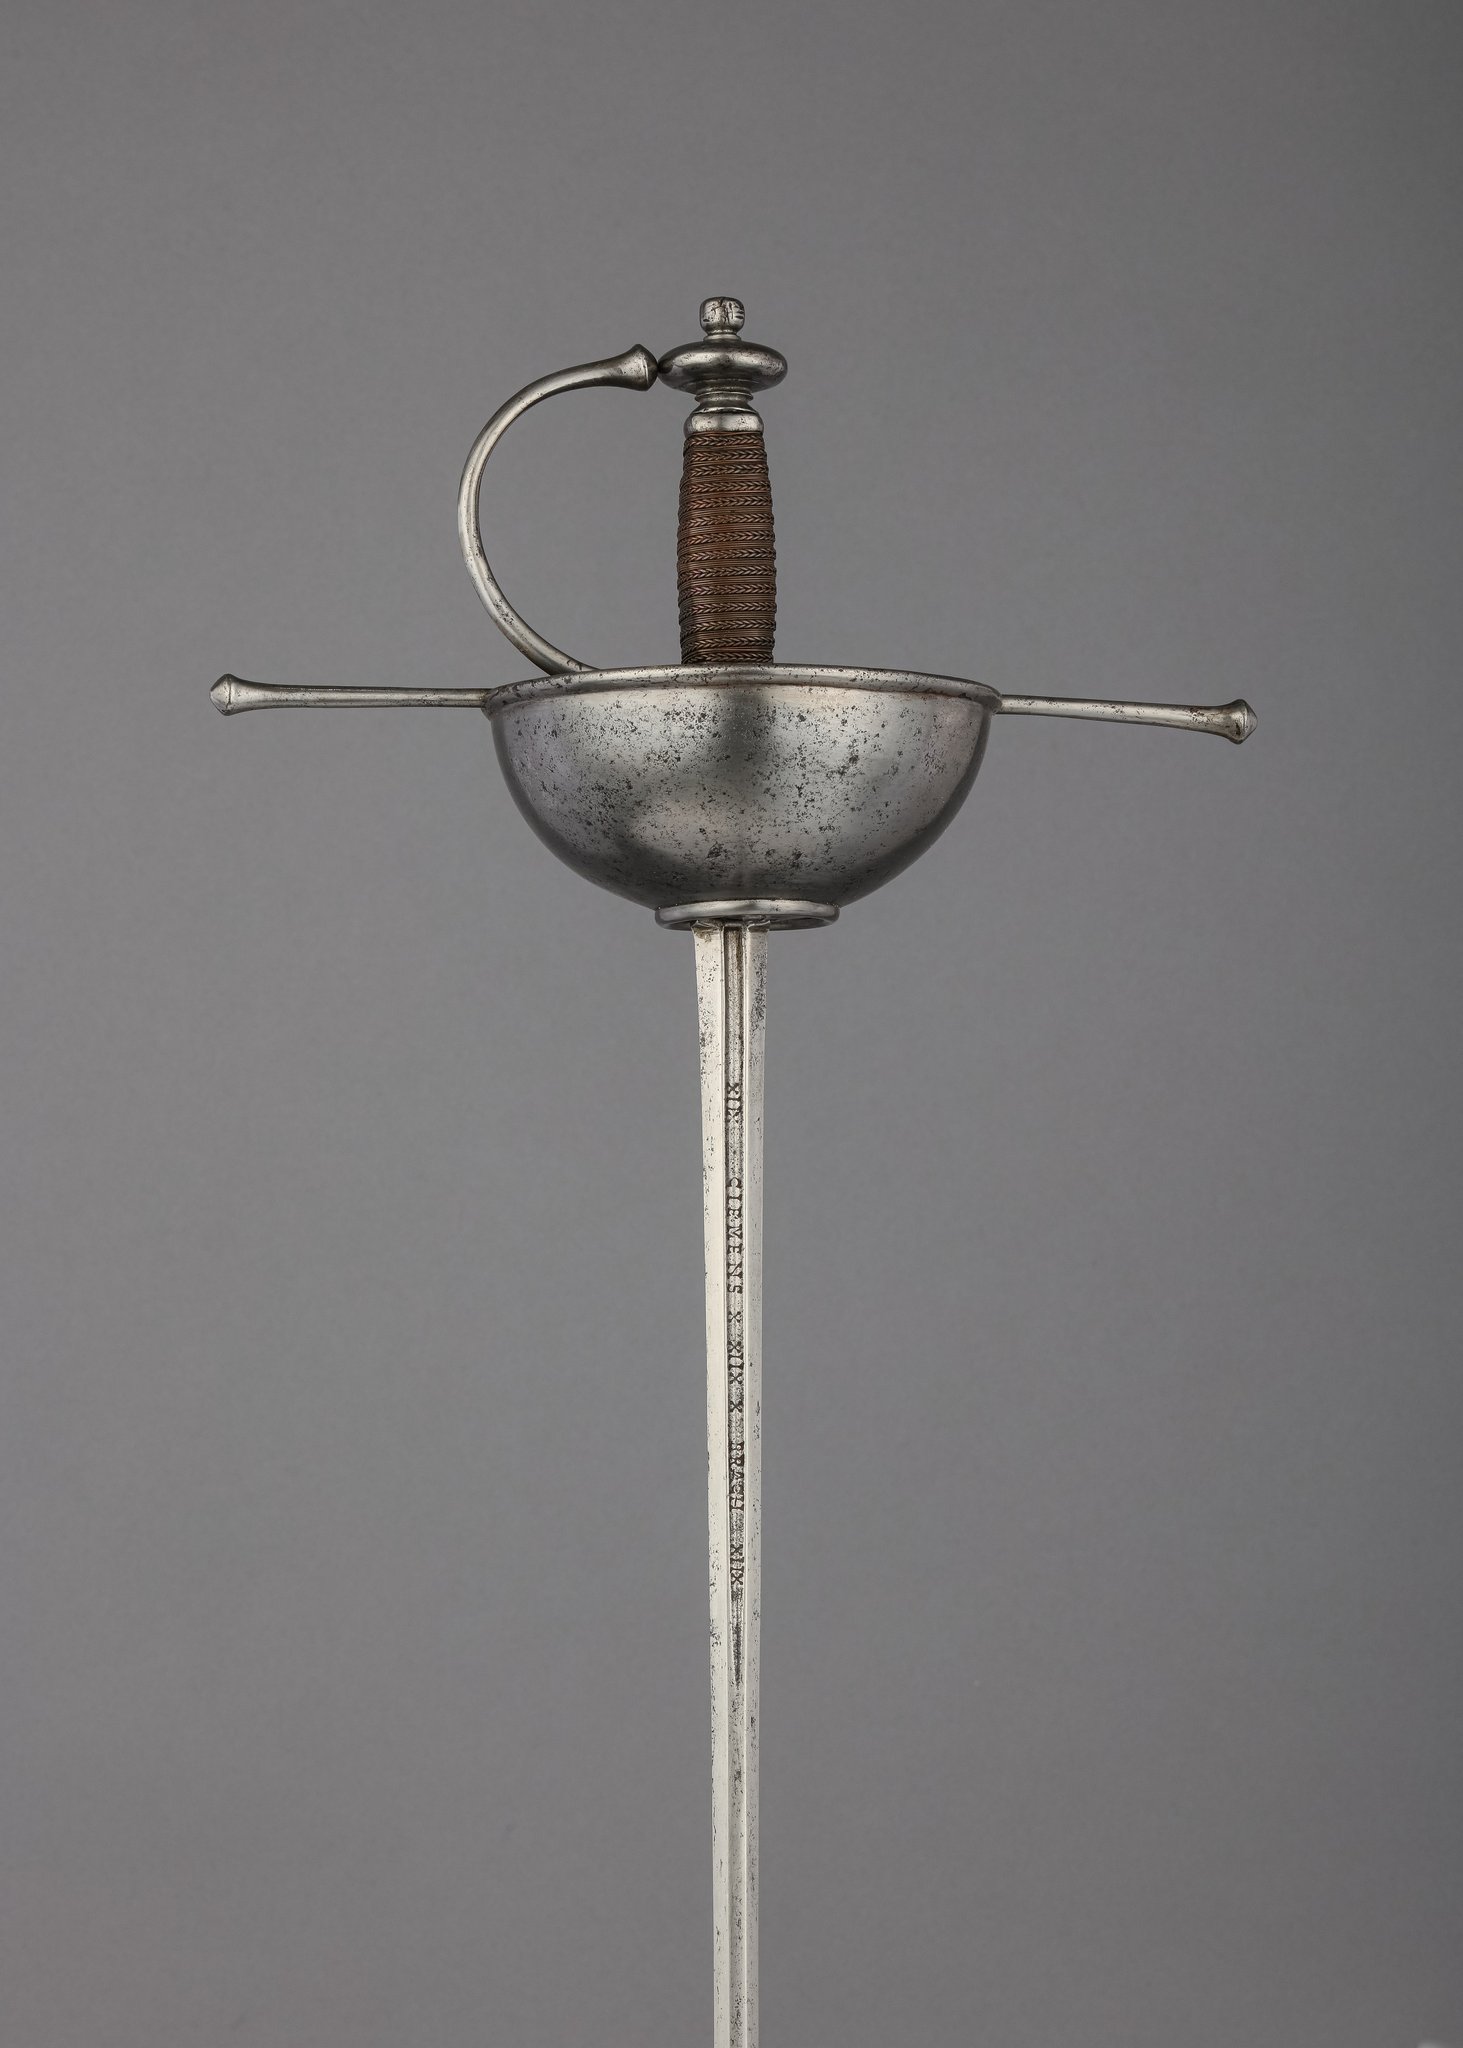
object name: cup hilted rapier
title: Cup-Hilted Rapier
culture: german or spanish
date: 1675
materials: copper, steel, metal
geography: germany